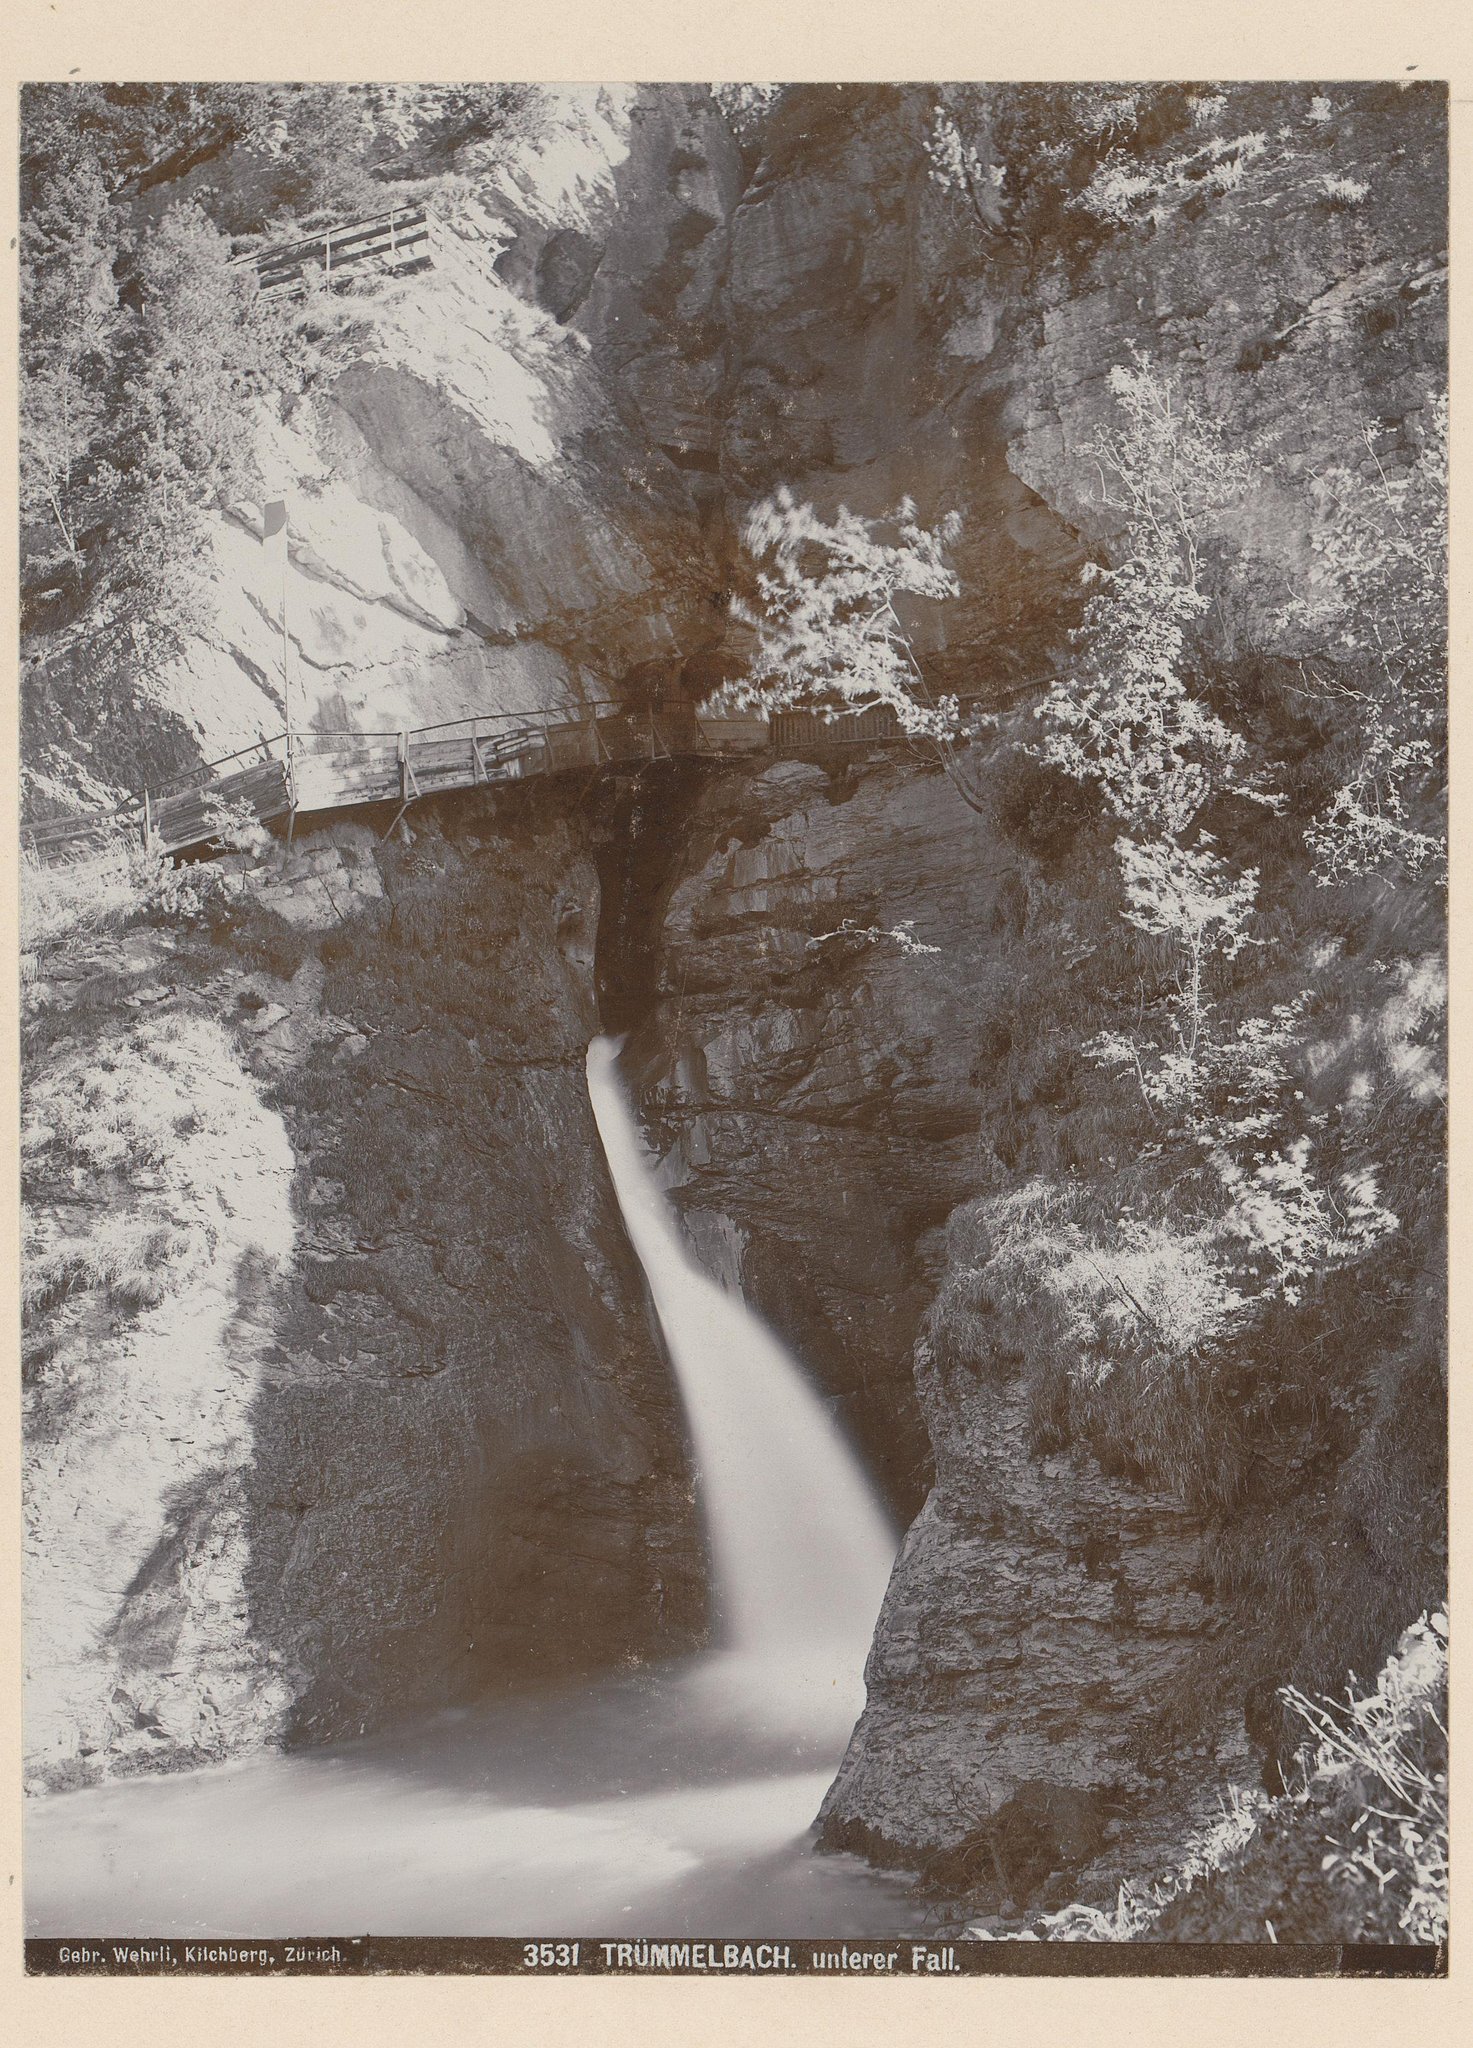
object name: photograph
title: Trümmelbachwaterval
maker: Anonymous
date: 1897-1910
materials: paper, cardboard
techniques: collodion silver print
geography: kilchberg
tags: waterfall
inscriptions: inscription: ‘Gebr. Wehrli, Kilchberg, Zürich. 3531 Trümmelbach. unterer Fall.’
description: Deze foto maakt deel uit van een omslag.